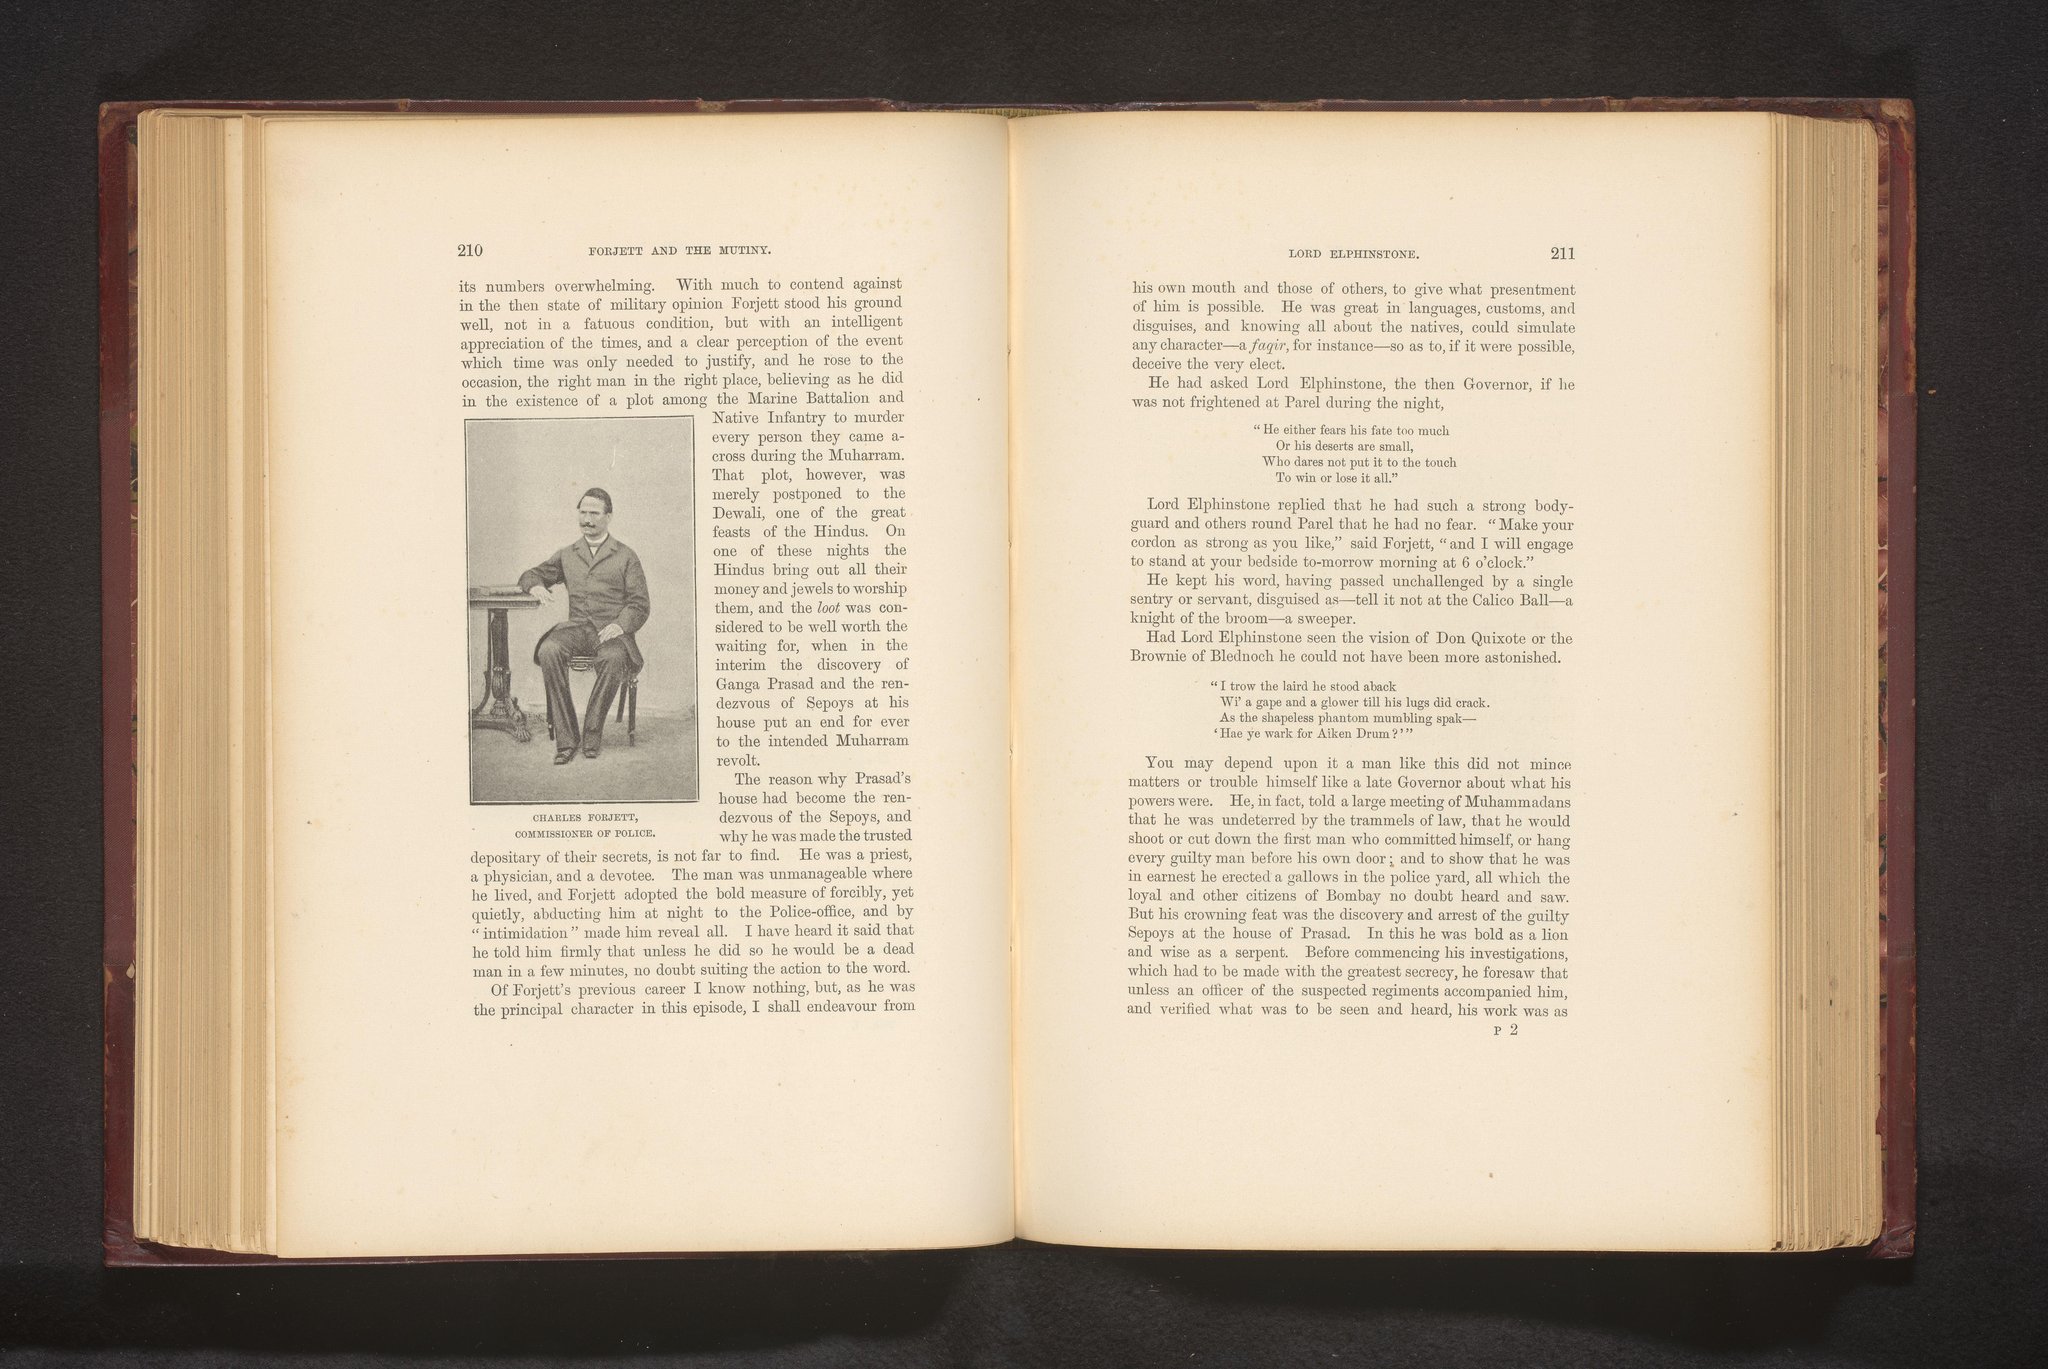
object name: photomechanical print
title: Photo reproduction of a painting depicting a portrait of Charles Forjett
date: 1883-1893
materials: paper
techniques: autotype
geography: paris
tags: policeman, constable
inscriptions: caption: ‘CHARLES FORJETT,/ COMMISSIONER OF POLICE.’